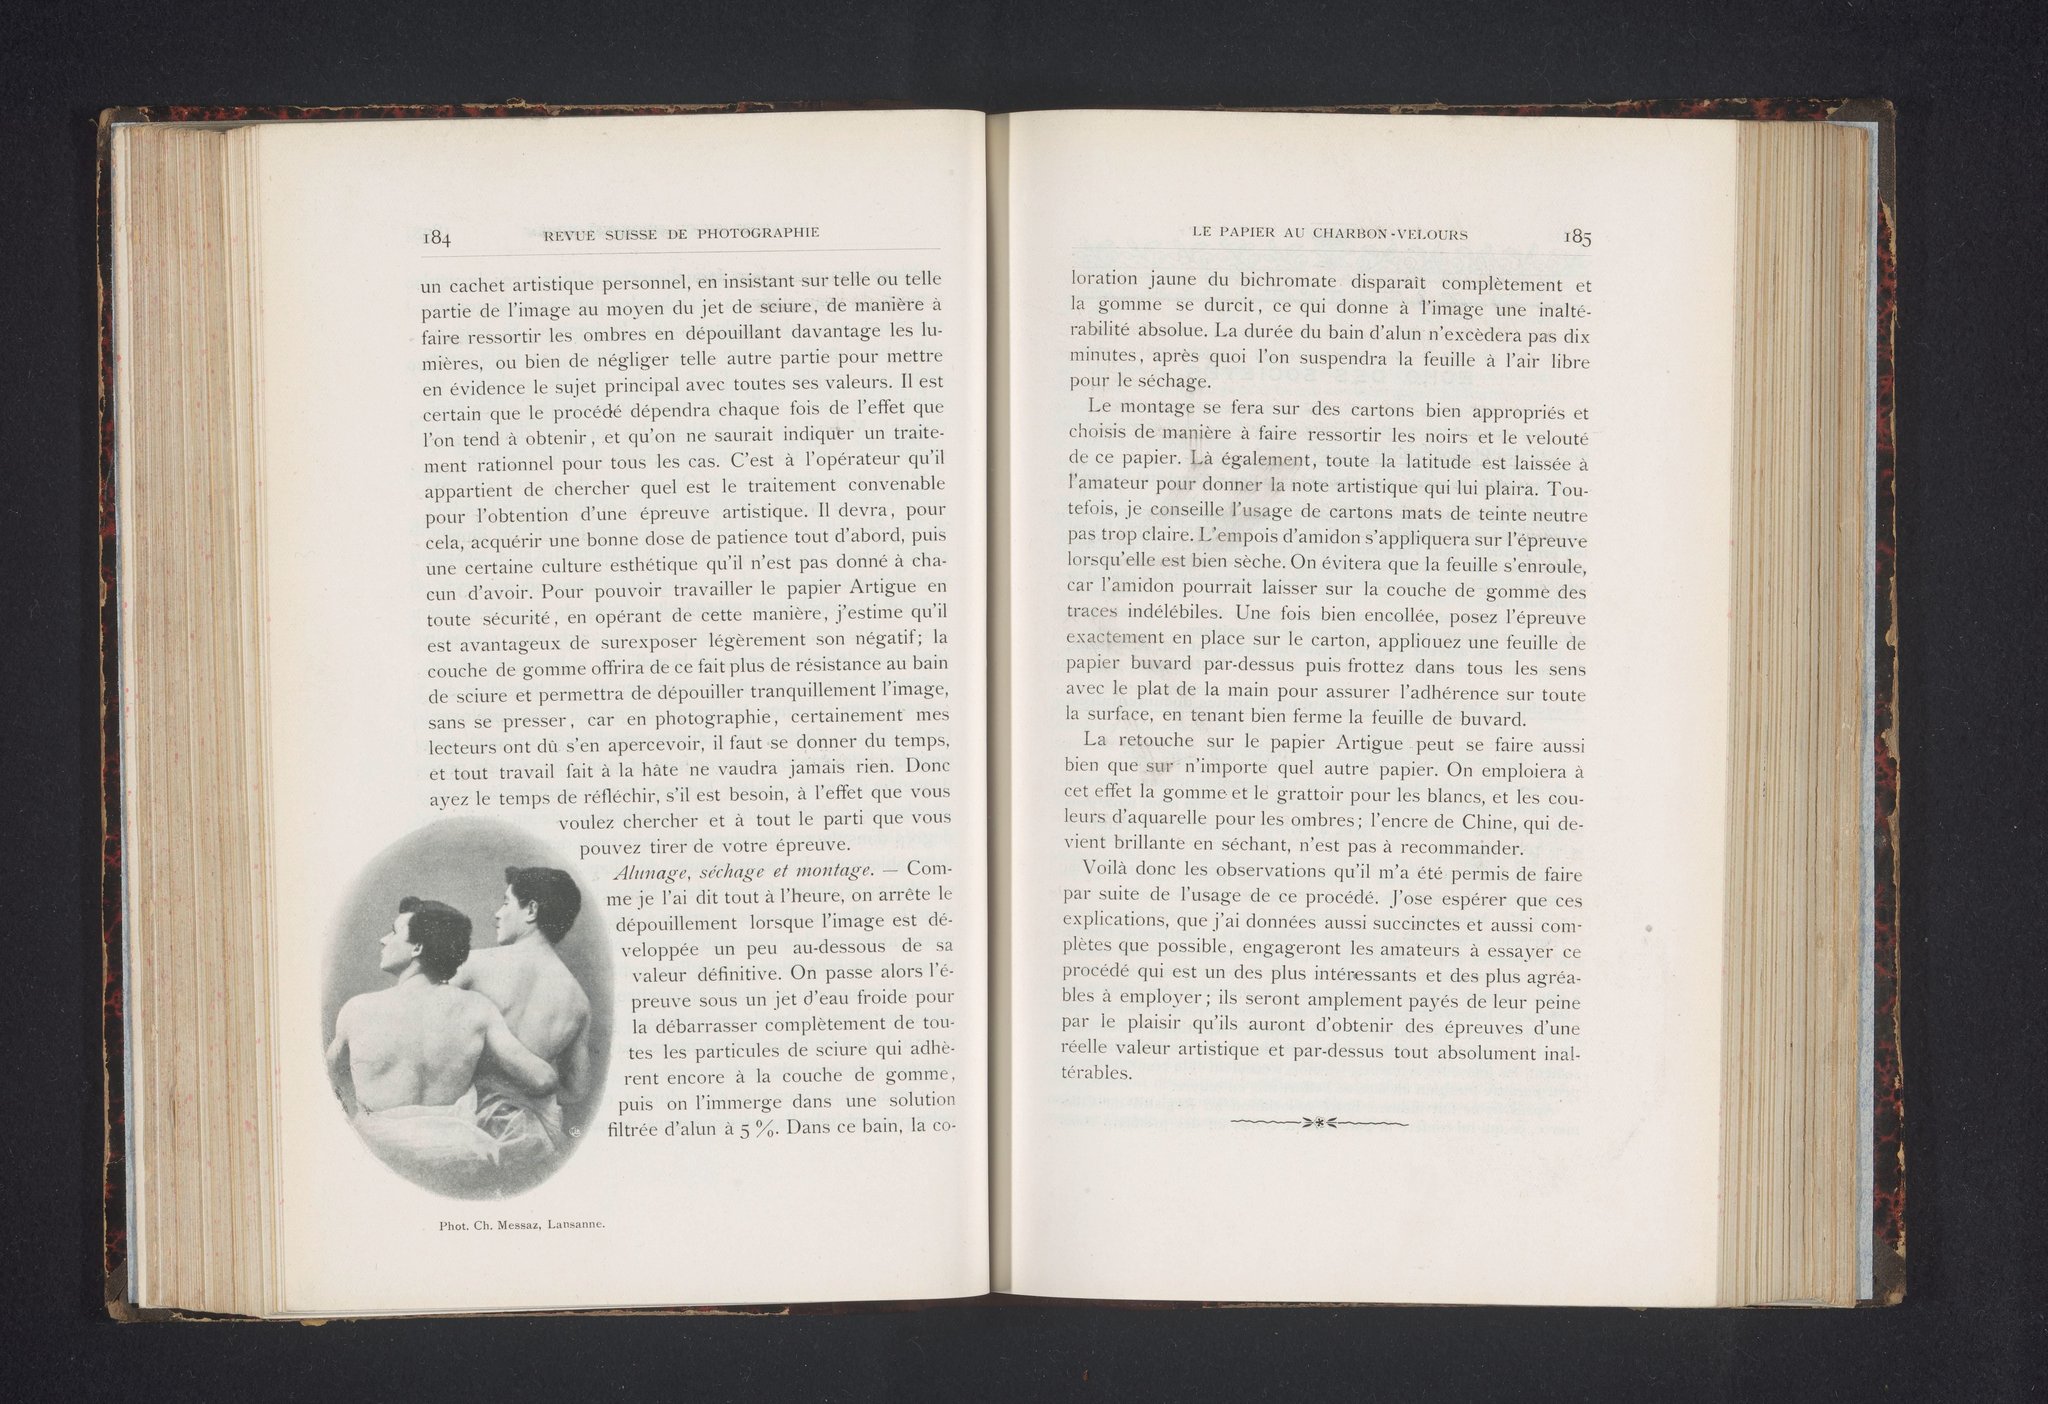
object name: page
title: Twee ontblote mannelijke ruggen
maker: charles messaz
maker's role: fotograaf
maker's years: 1866-1928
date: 1897-1902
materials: paper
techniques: autotype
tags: historical persons, back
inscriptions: monogram: ‘C. Cie’